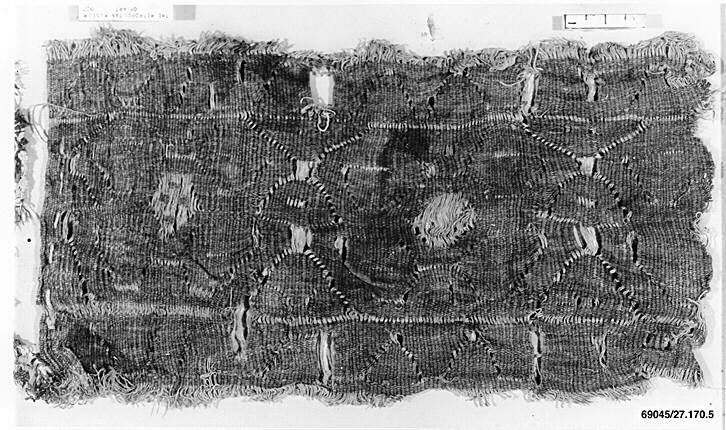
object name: band fragment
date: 901-1100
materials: cotton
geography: egypt